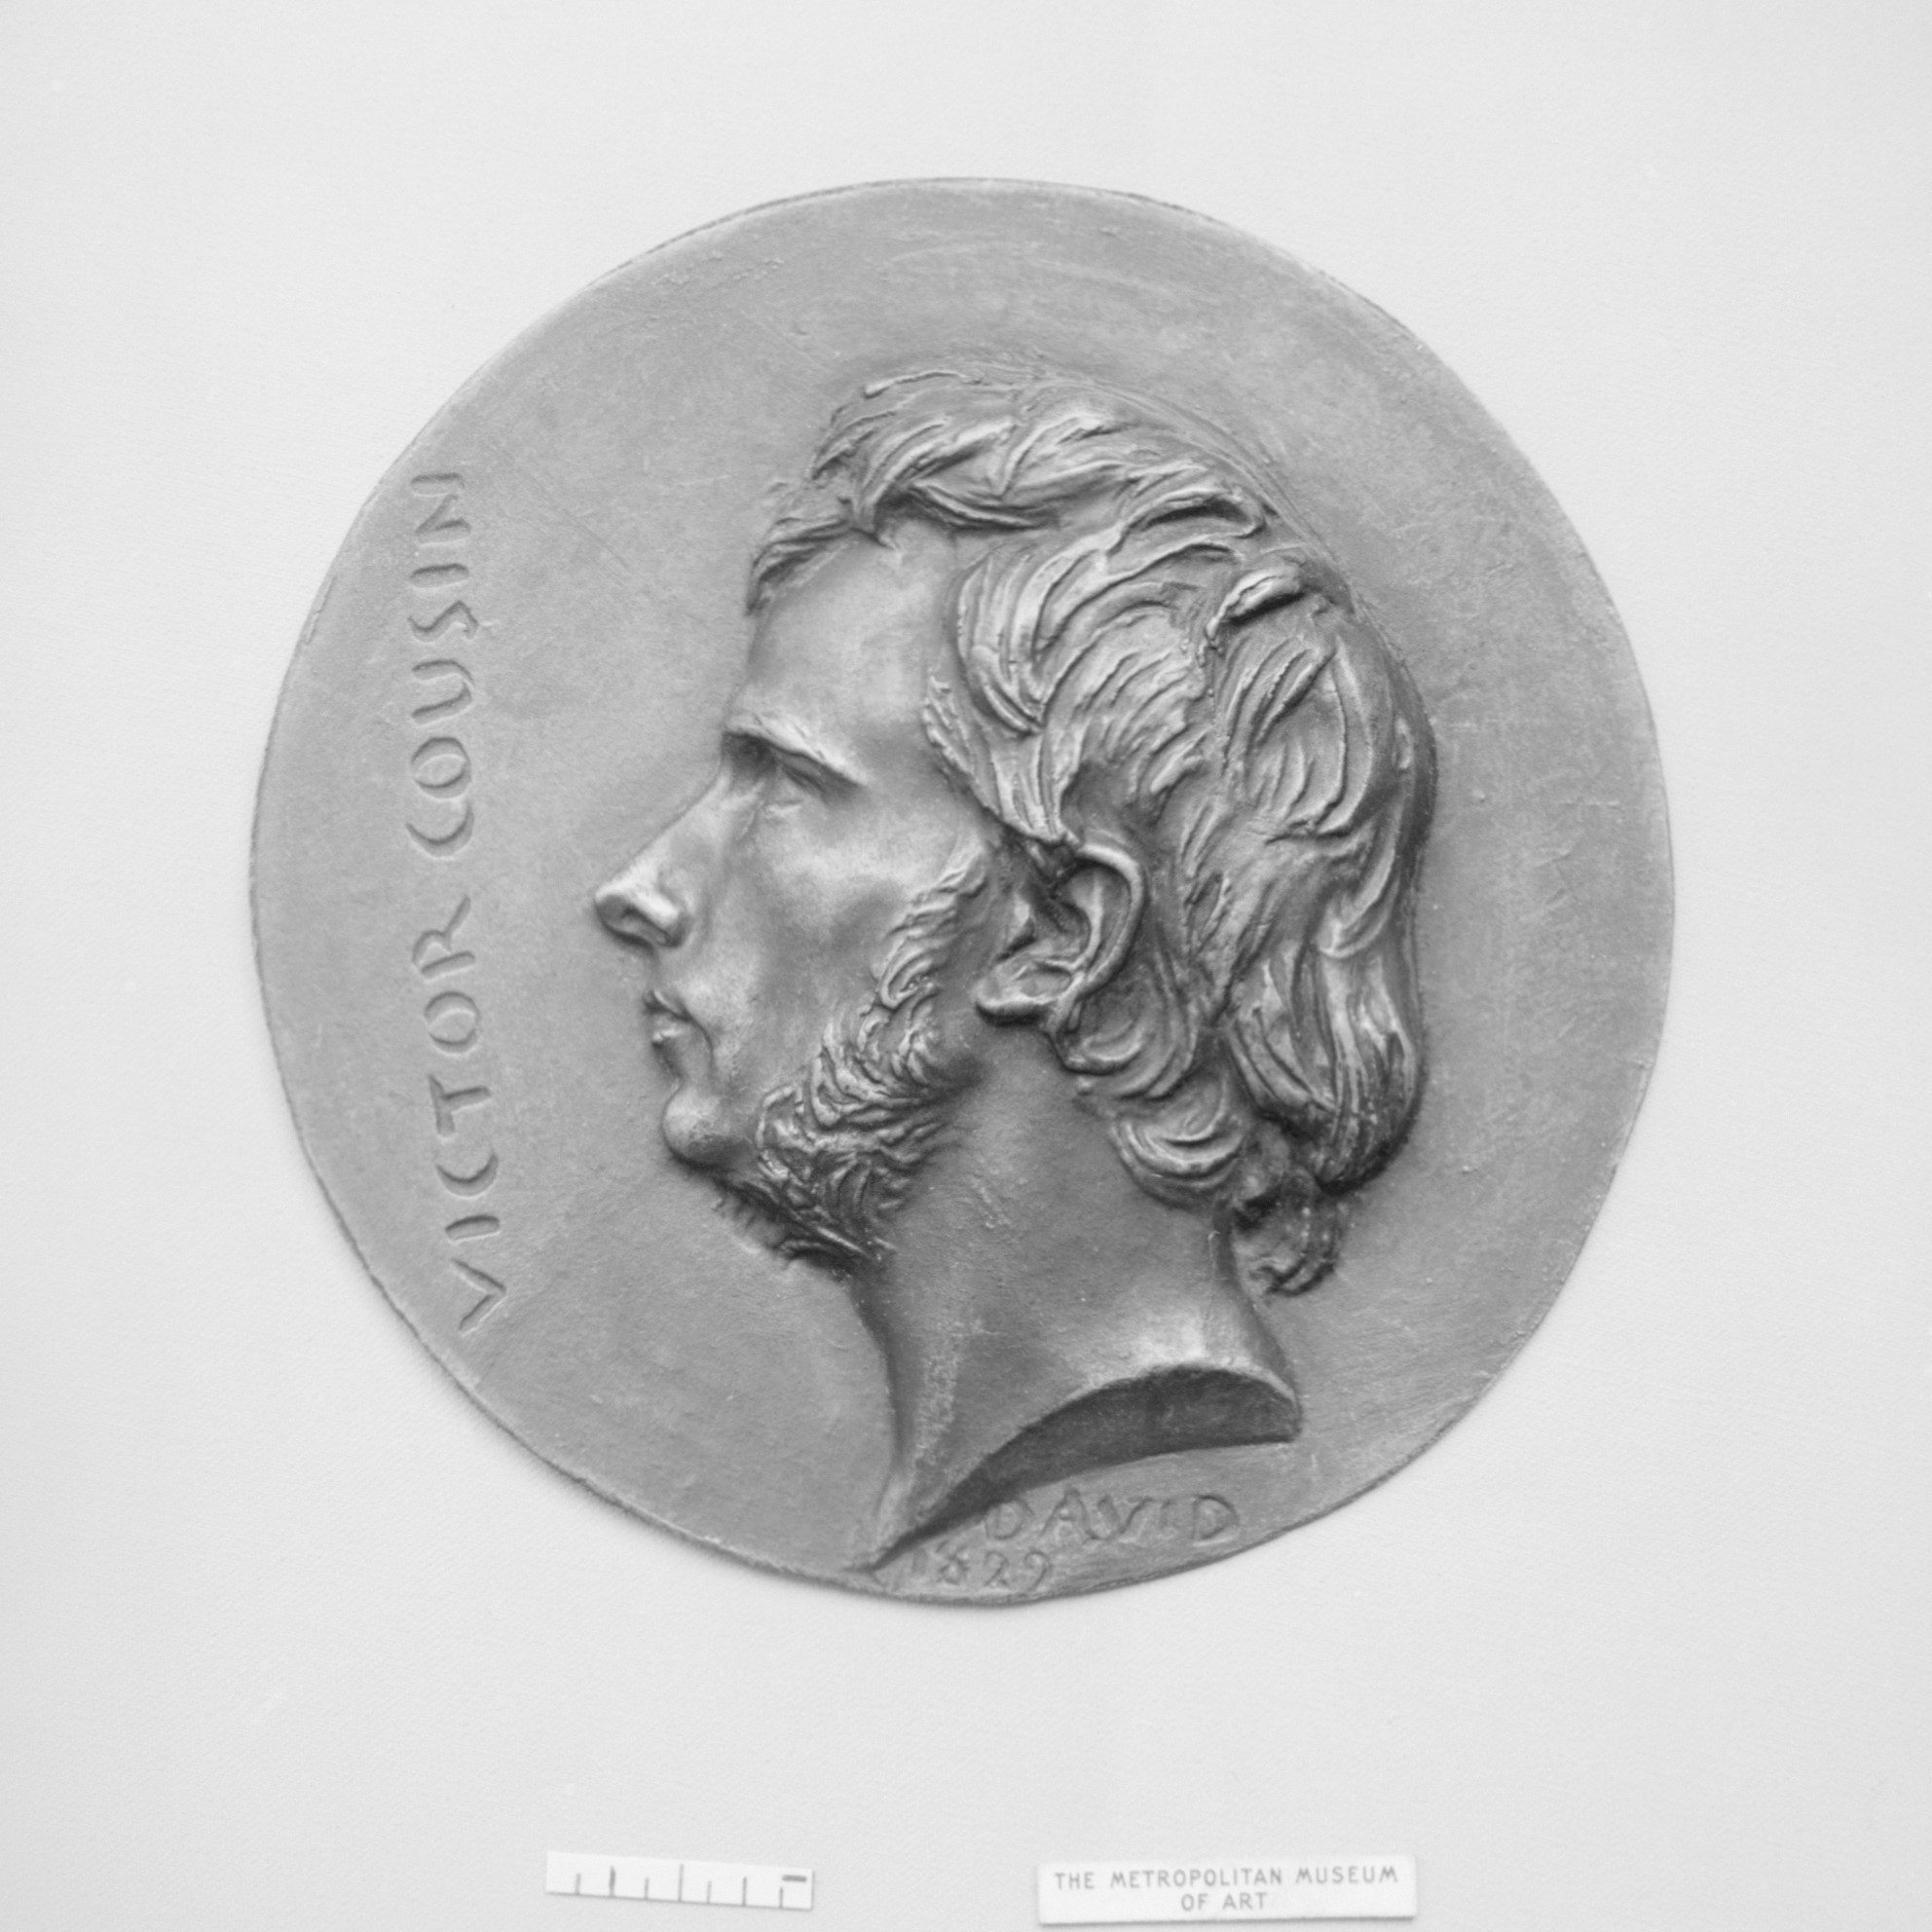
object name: medallion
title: Victor Cousin (1792–1867), French philosopher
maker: pierre jean david d'angers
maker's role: artist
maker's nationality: french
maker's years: 1788-1856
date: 1829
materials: bronze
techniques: casting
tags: men,profiles,philosophers